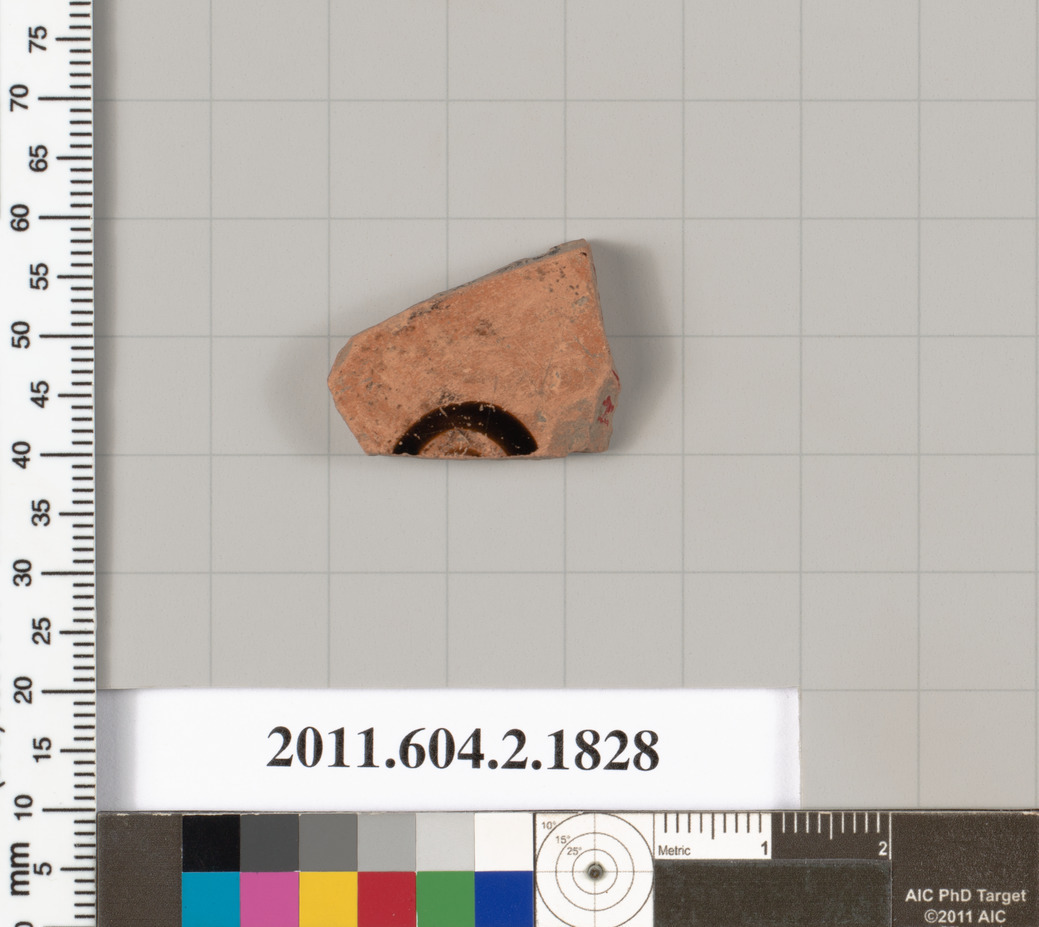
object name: skyphos fragment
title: Terracotta fragment of a skyphos (deep drinking cup)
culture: greek, attic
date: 450-401 BCE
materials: terracotta